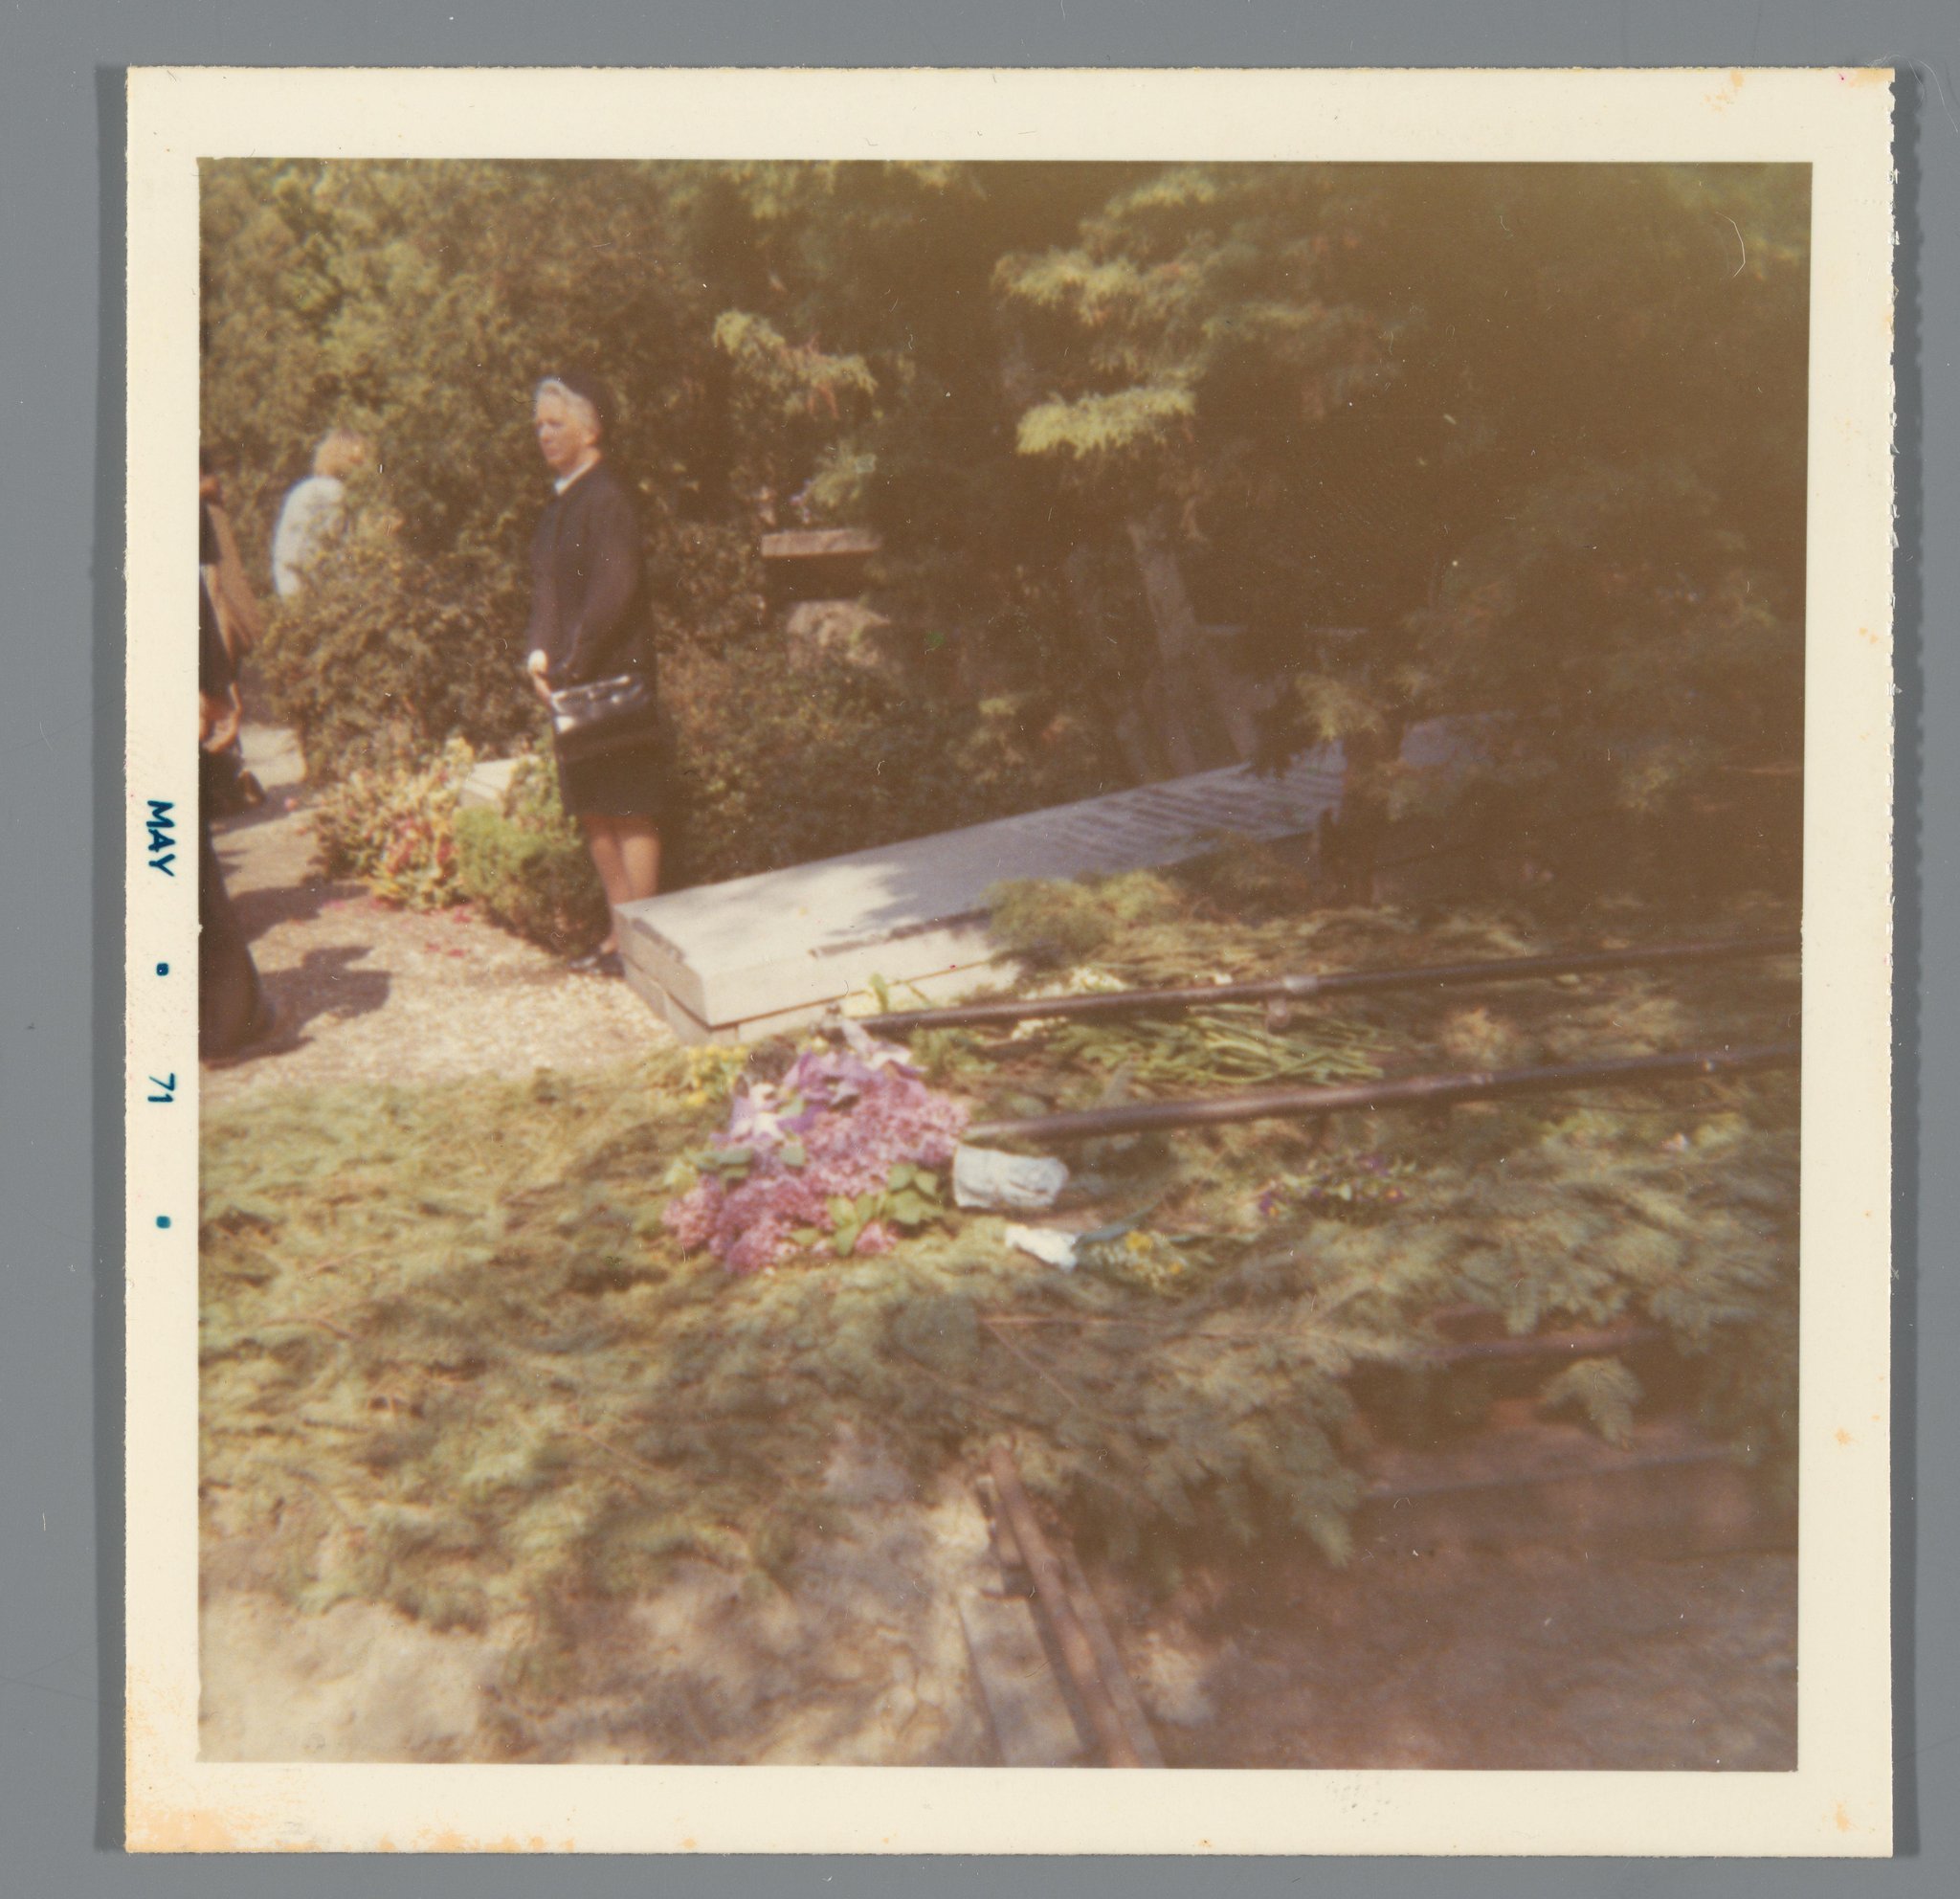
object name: photograph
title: Graf met bloemen tijdens een begrafenis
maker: cornelia hendrika jonker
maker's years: 1874-1924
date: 1971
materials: photographic support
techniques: chromogenic print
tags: historical persons, funerary ceremonial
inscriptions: stamp: ‘Kodacolor Print’, annotation: ‘[...]’, inscription: ‘May 71’